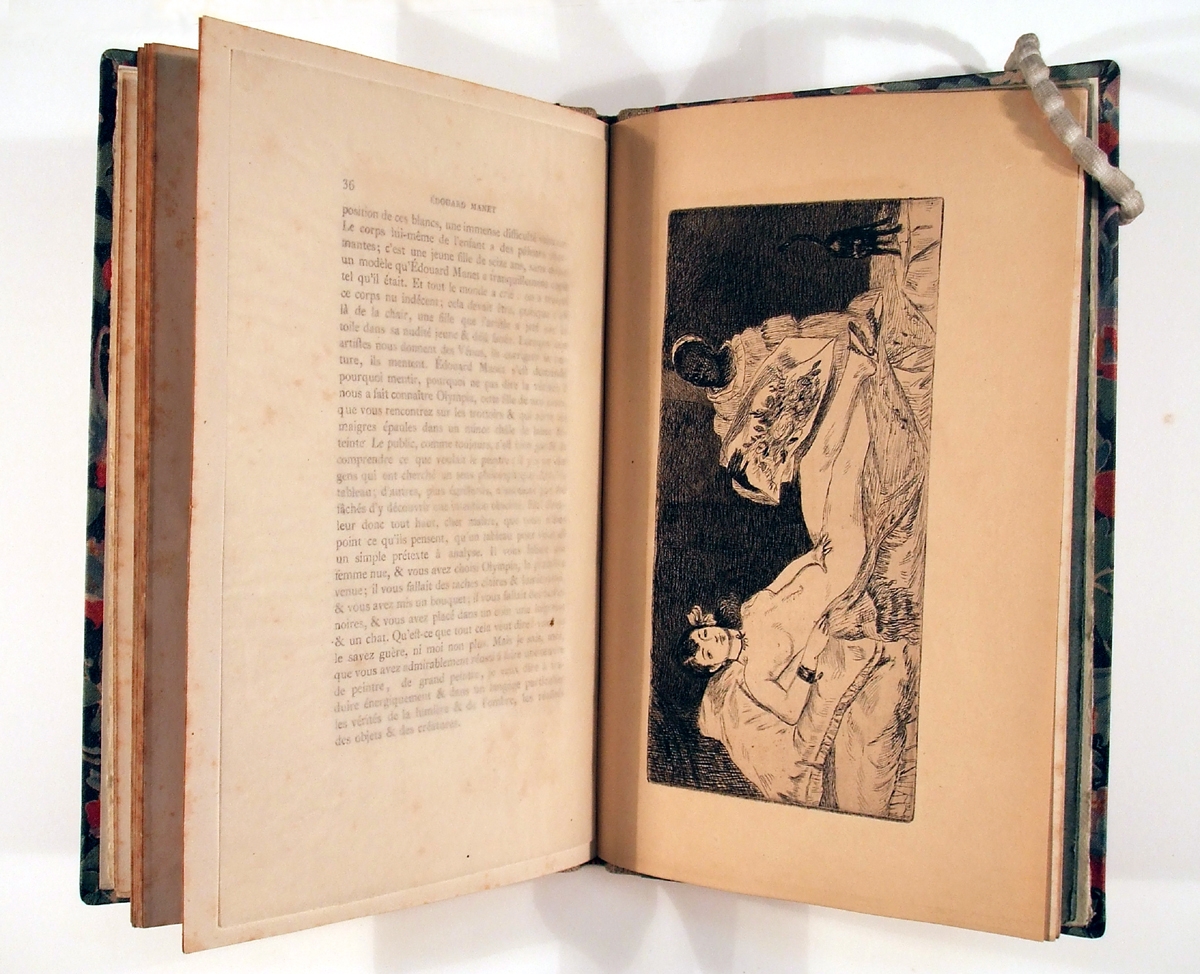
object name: book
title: Edouard Manet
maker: emile zola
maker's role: author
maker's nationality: french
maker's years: 1840-1902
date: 1867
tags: men,female nudes